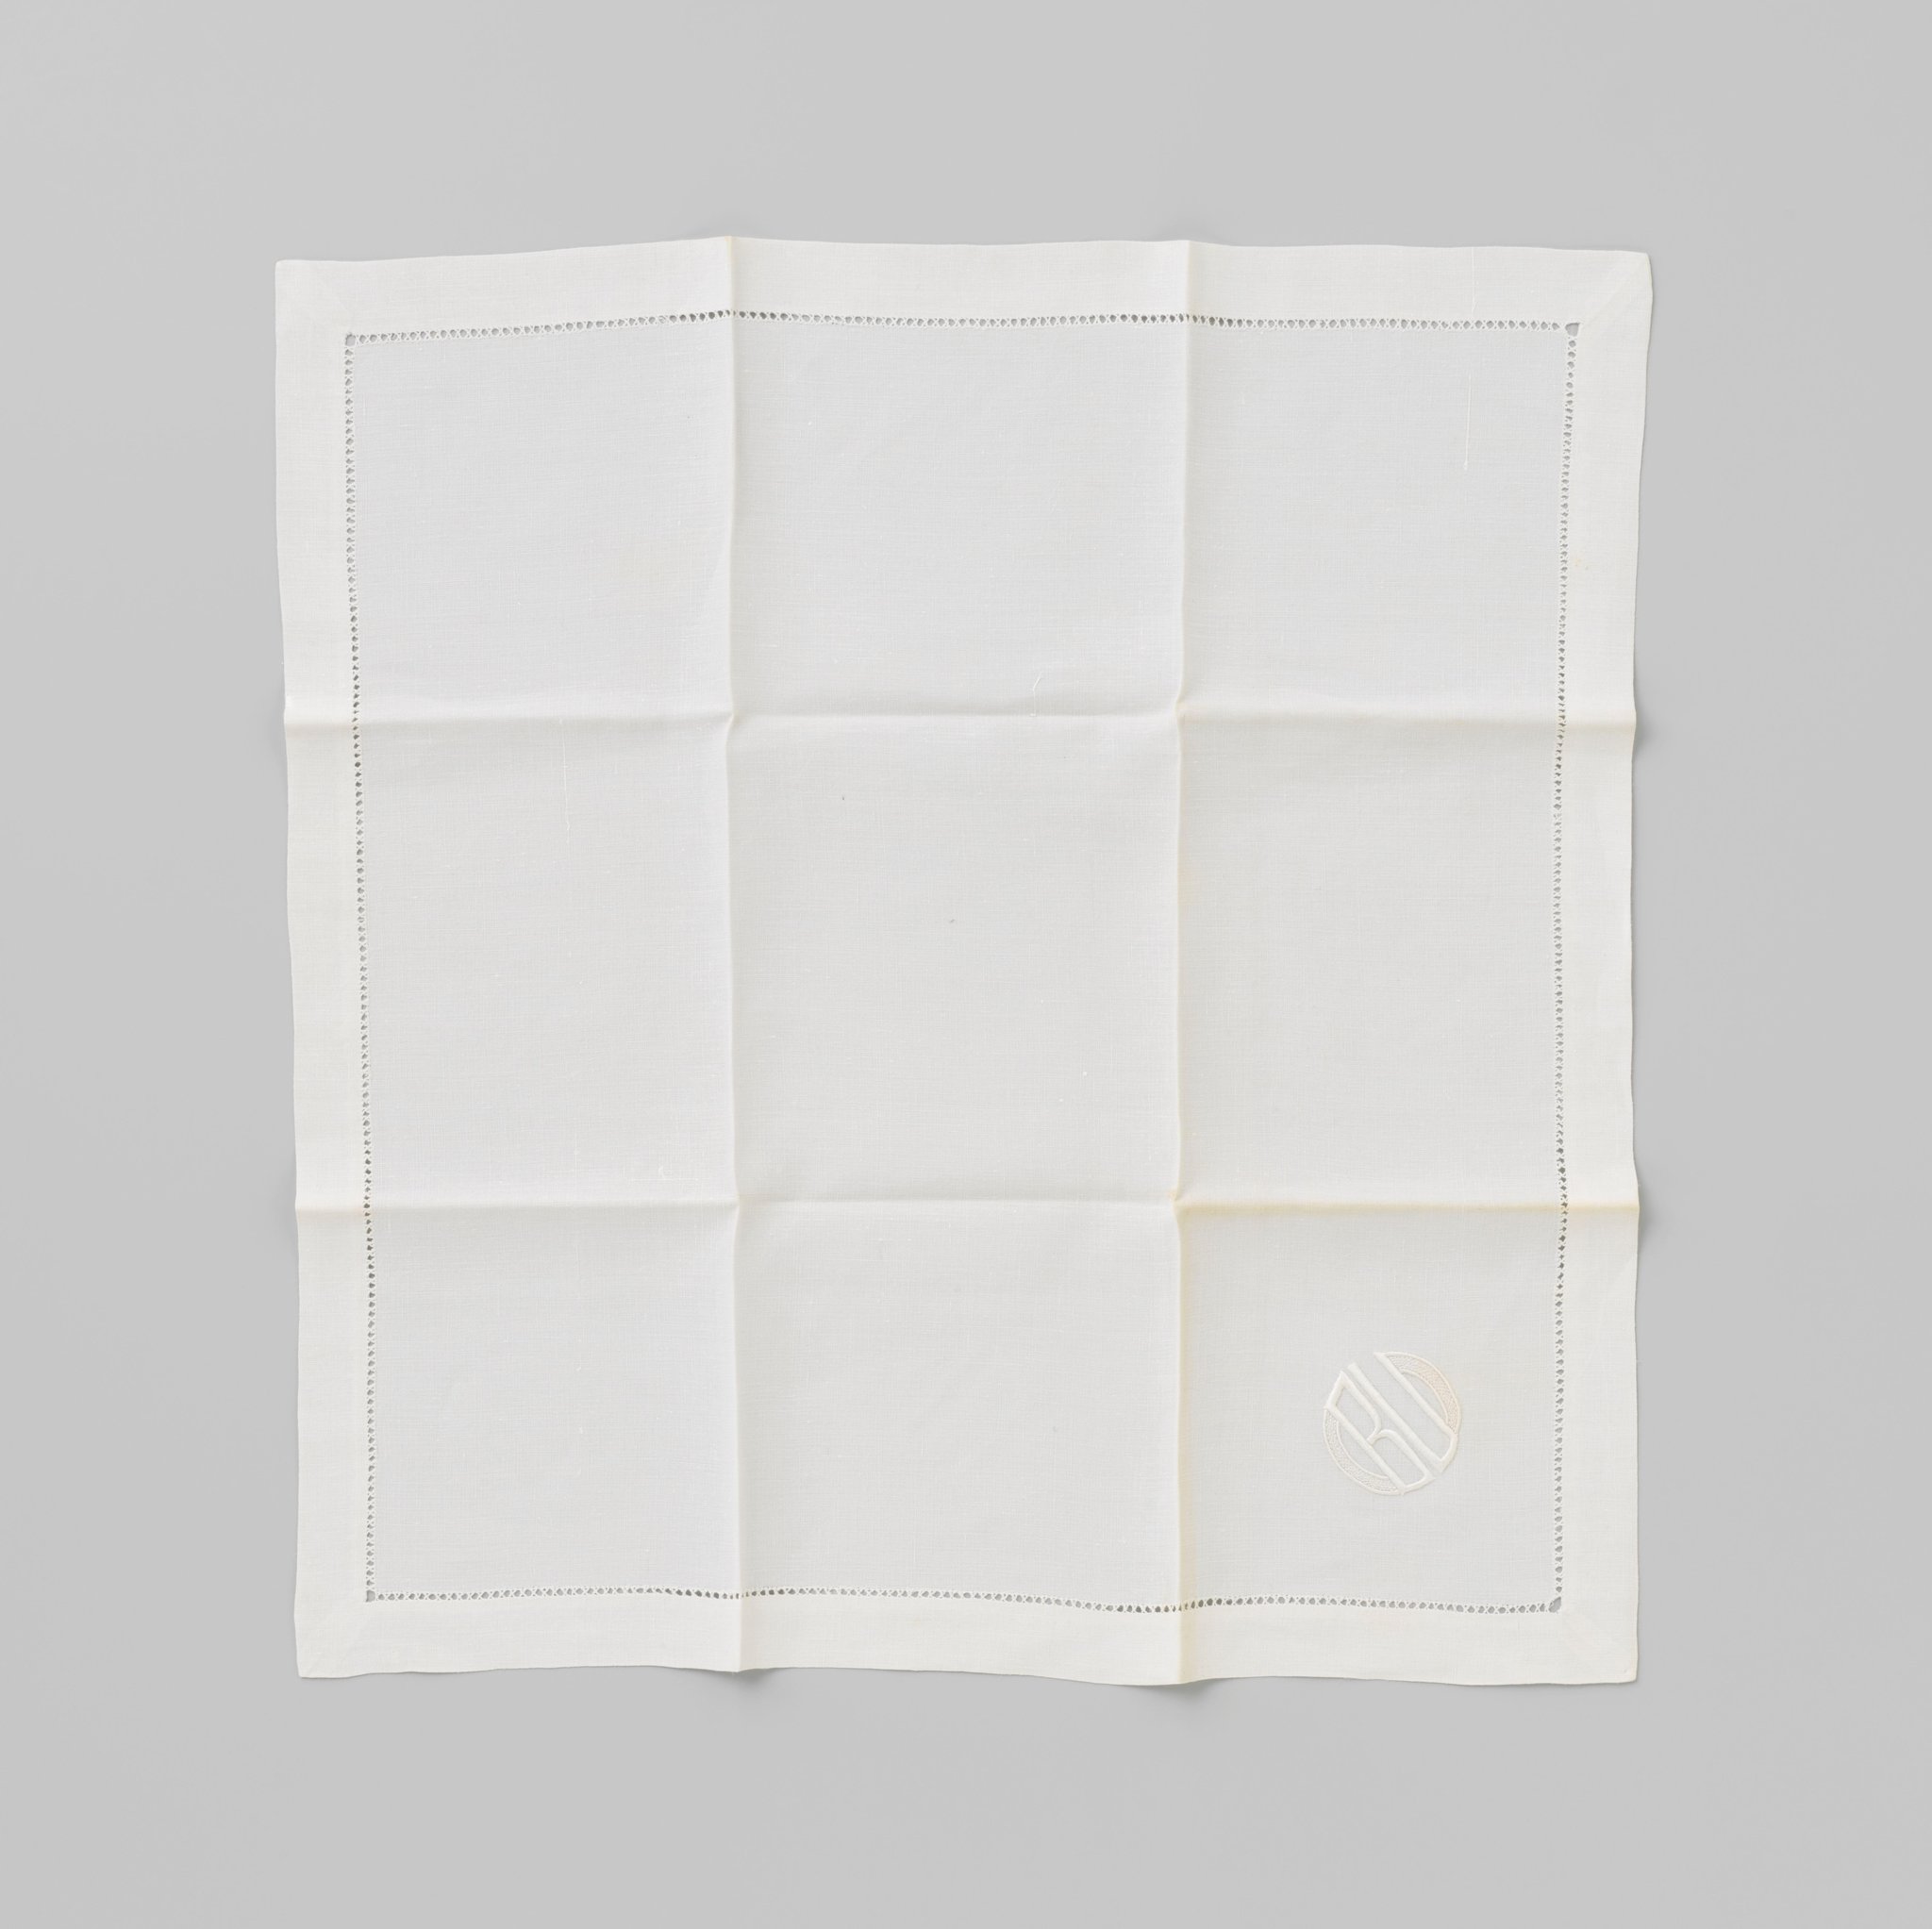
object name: napkin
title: Servet van linnen met de geborduurde initialen BU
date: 1935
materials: linen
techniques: embroidered, weave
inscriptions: initials: ‘BU’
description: Servet van linnen in platbinding, met opengewerkte zomen en de geborduurde initialen BU (Brusse-Urtebise).